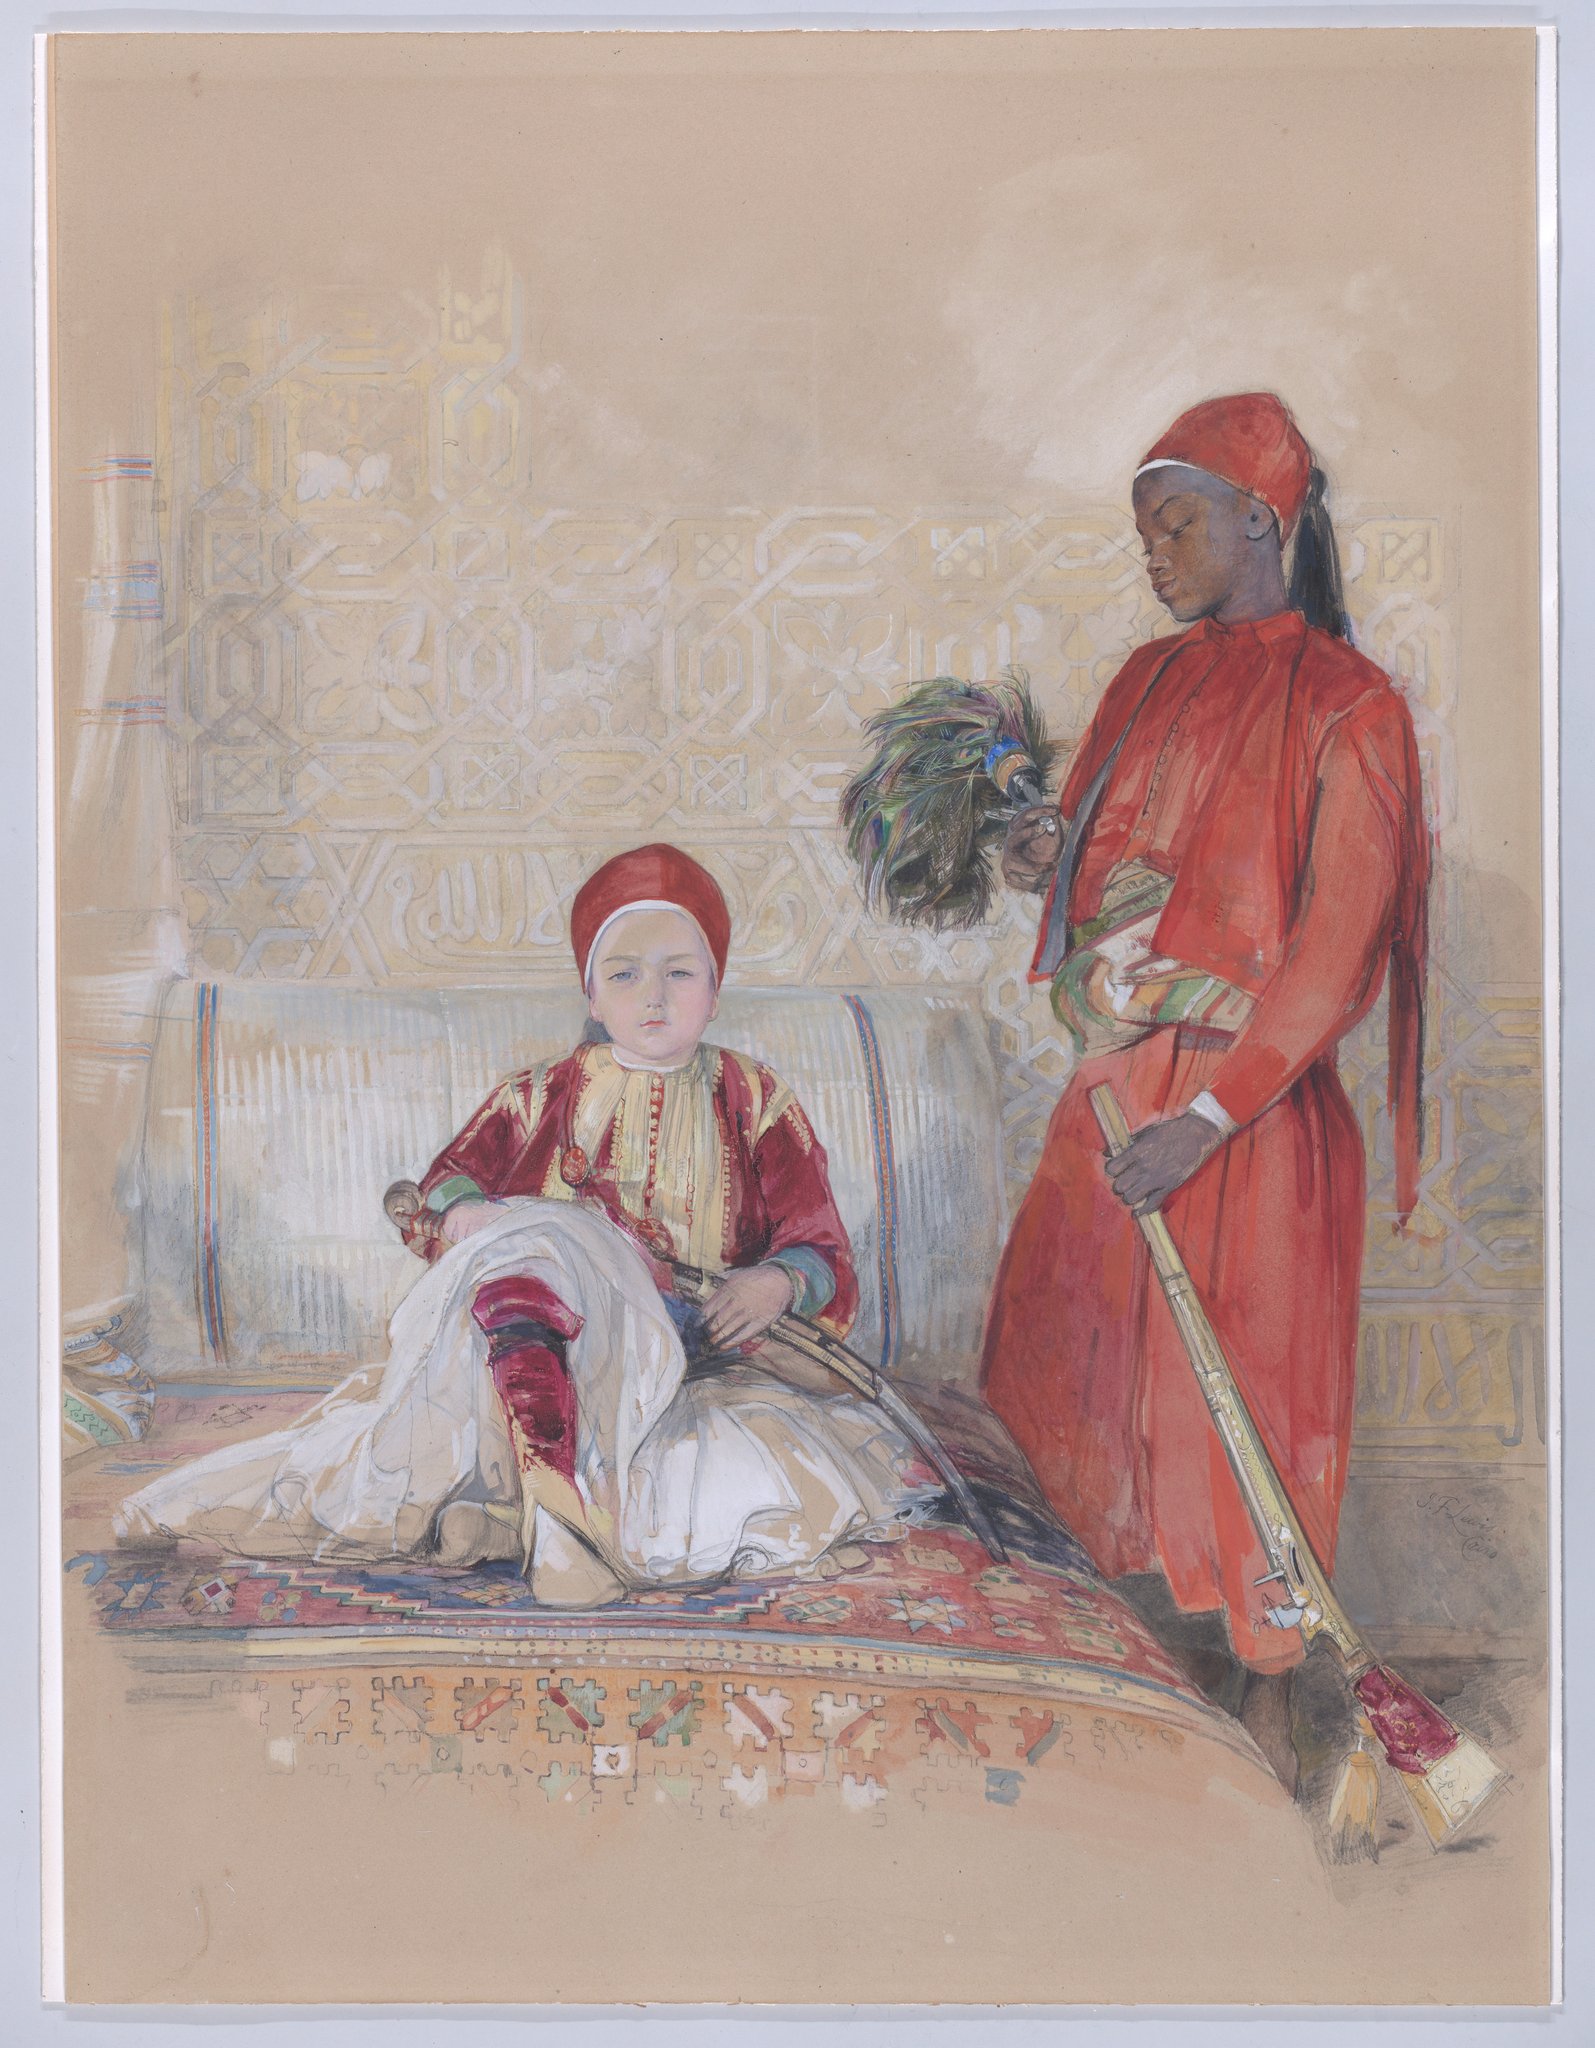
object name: drawing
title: Iskander Bey and His Servant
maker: john frederick lewis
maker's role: artist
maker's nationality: british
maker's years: 1804-1876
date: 1848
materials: gouache, graphite, watercolor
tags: boys,servants